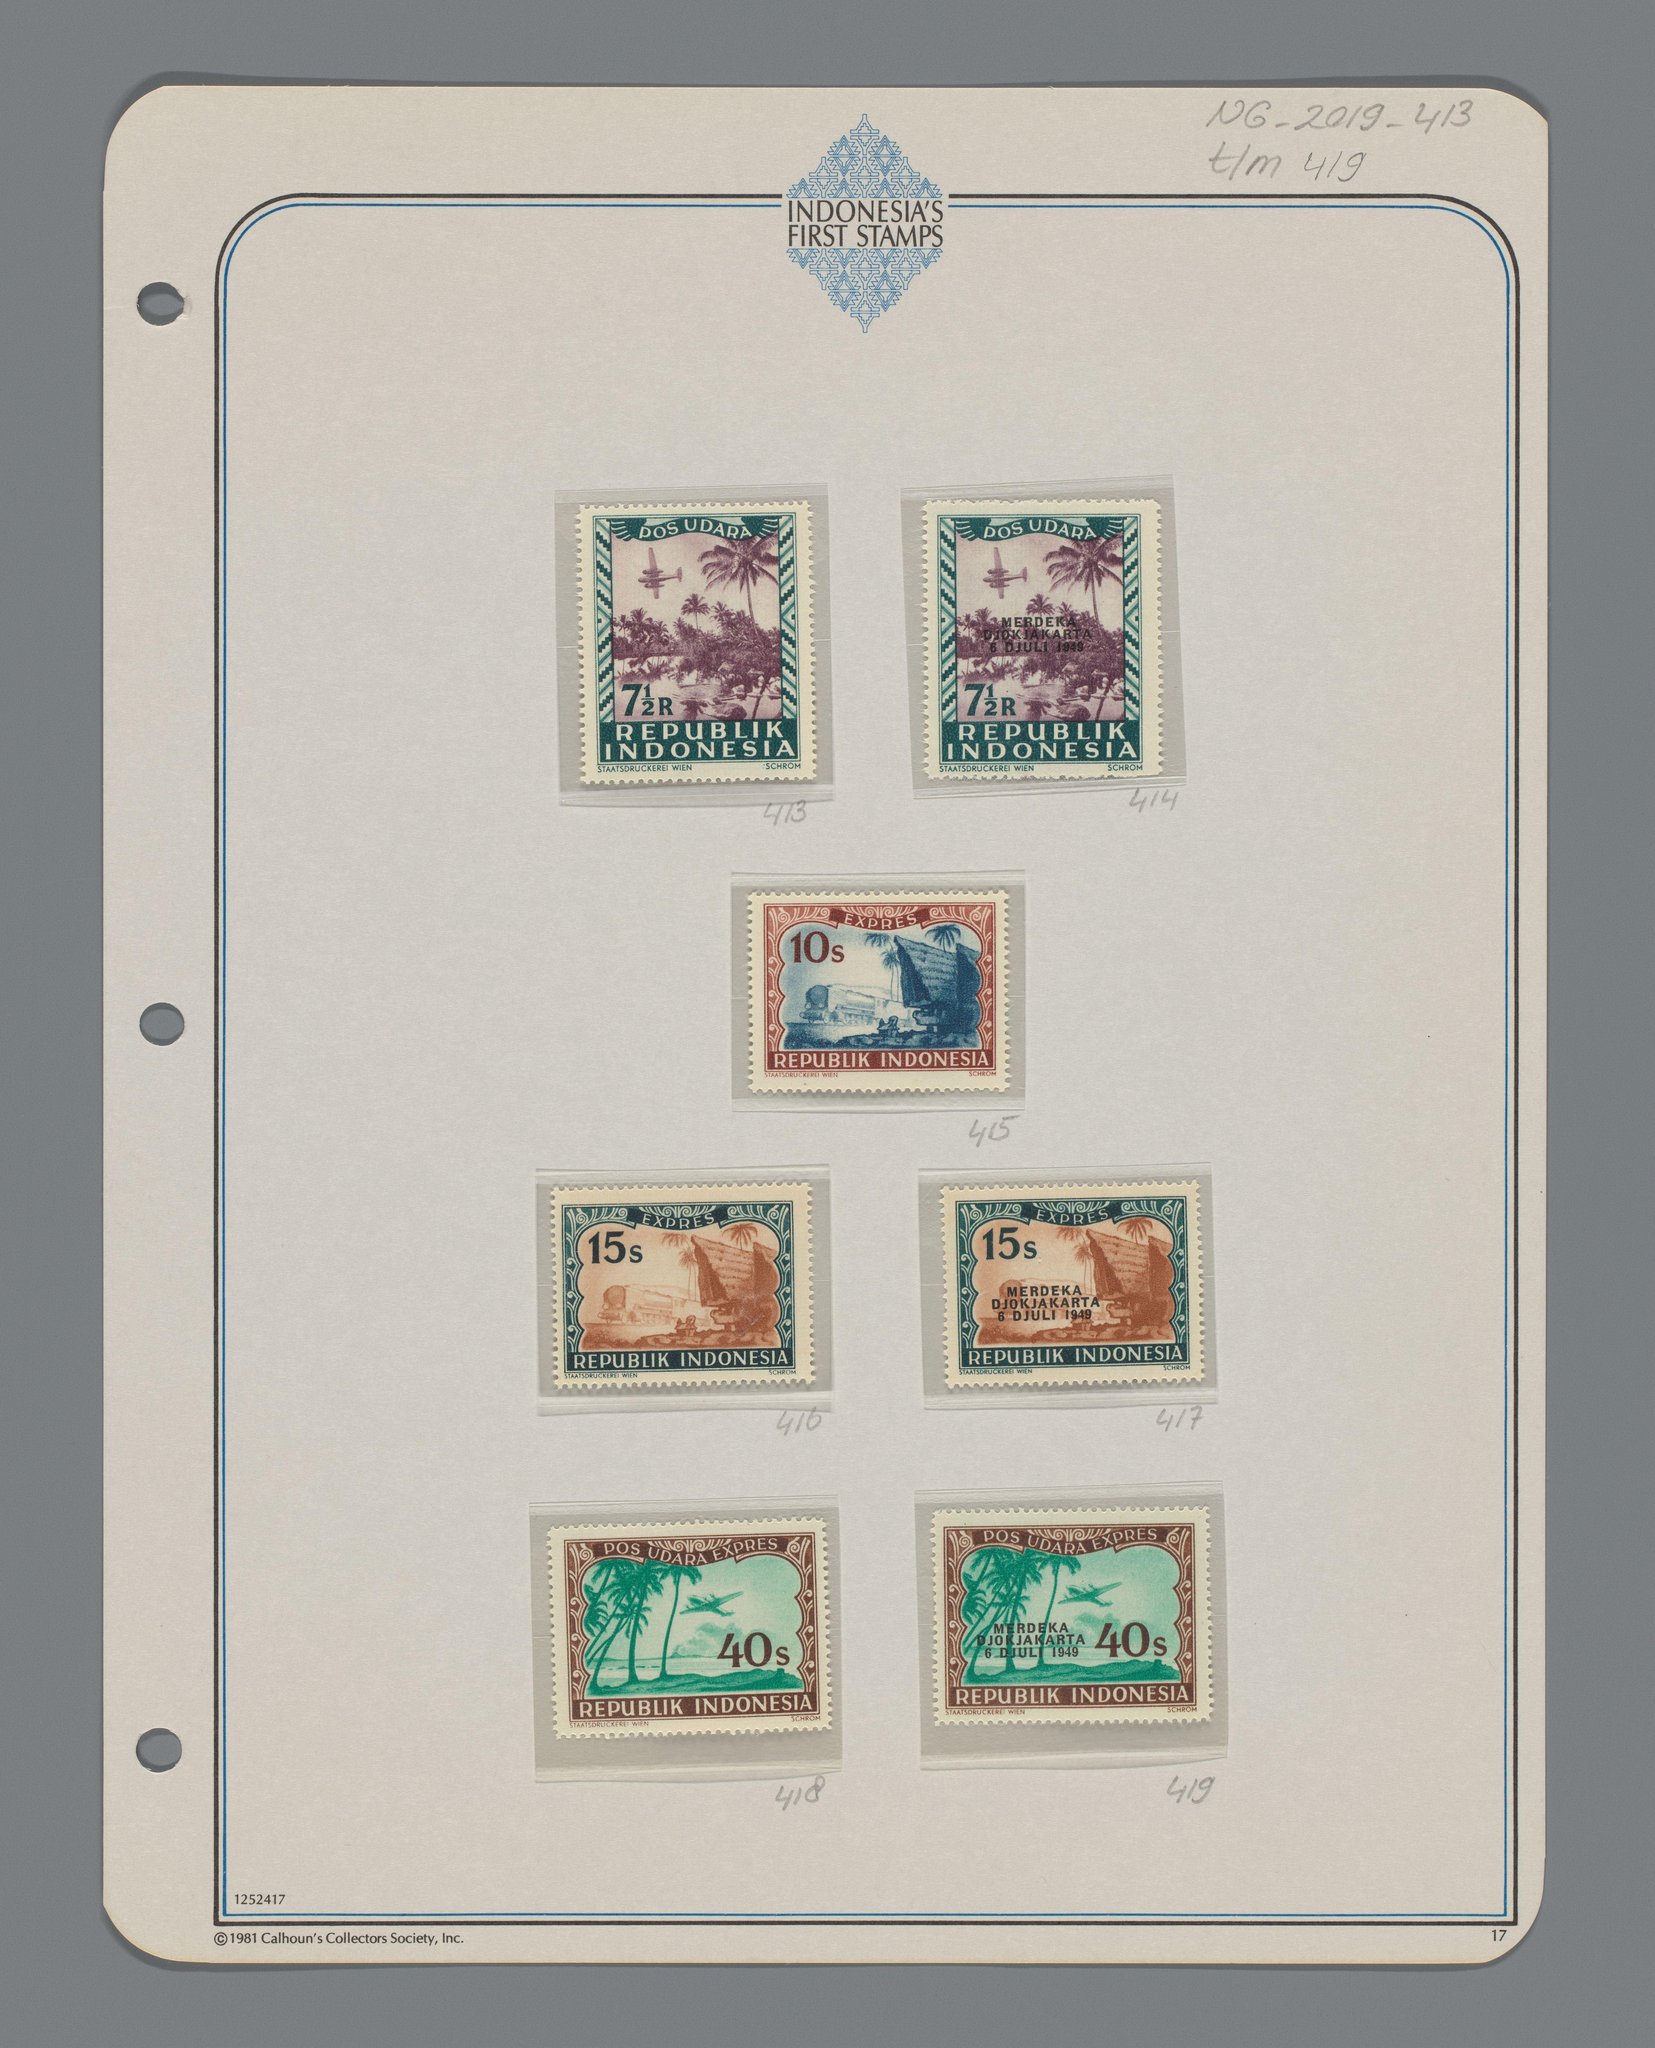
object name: postage stamp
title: Postzegel Republik Indonesia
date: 1949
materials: paper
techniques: photoaquatint, engraving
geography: philadelphia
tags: indonesia